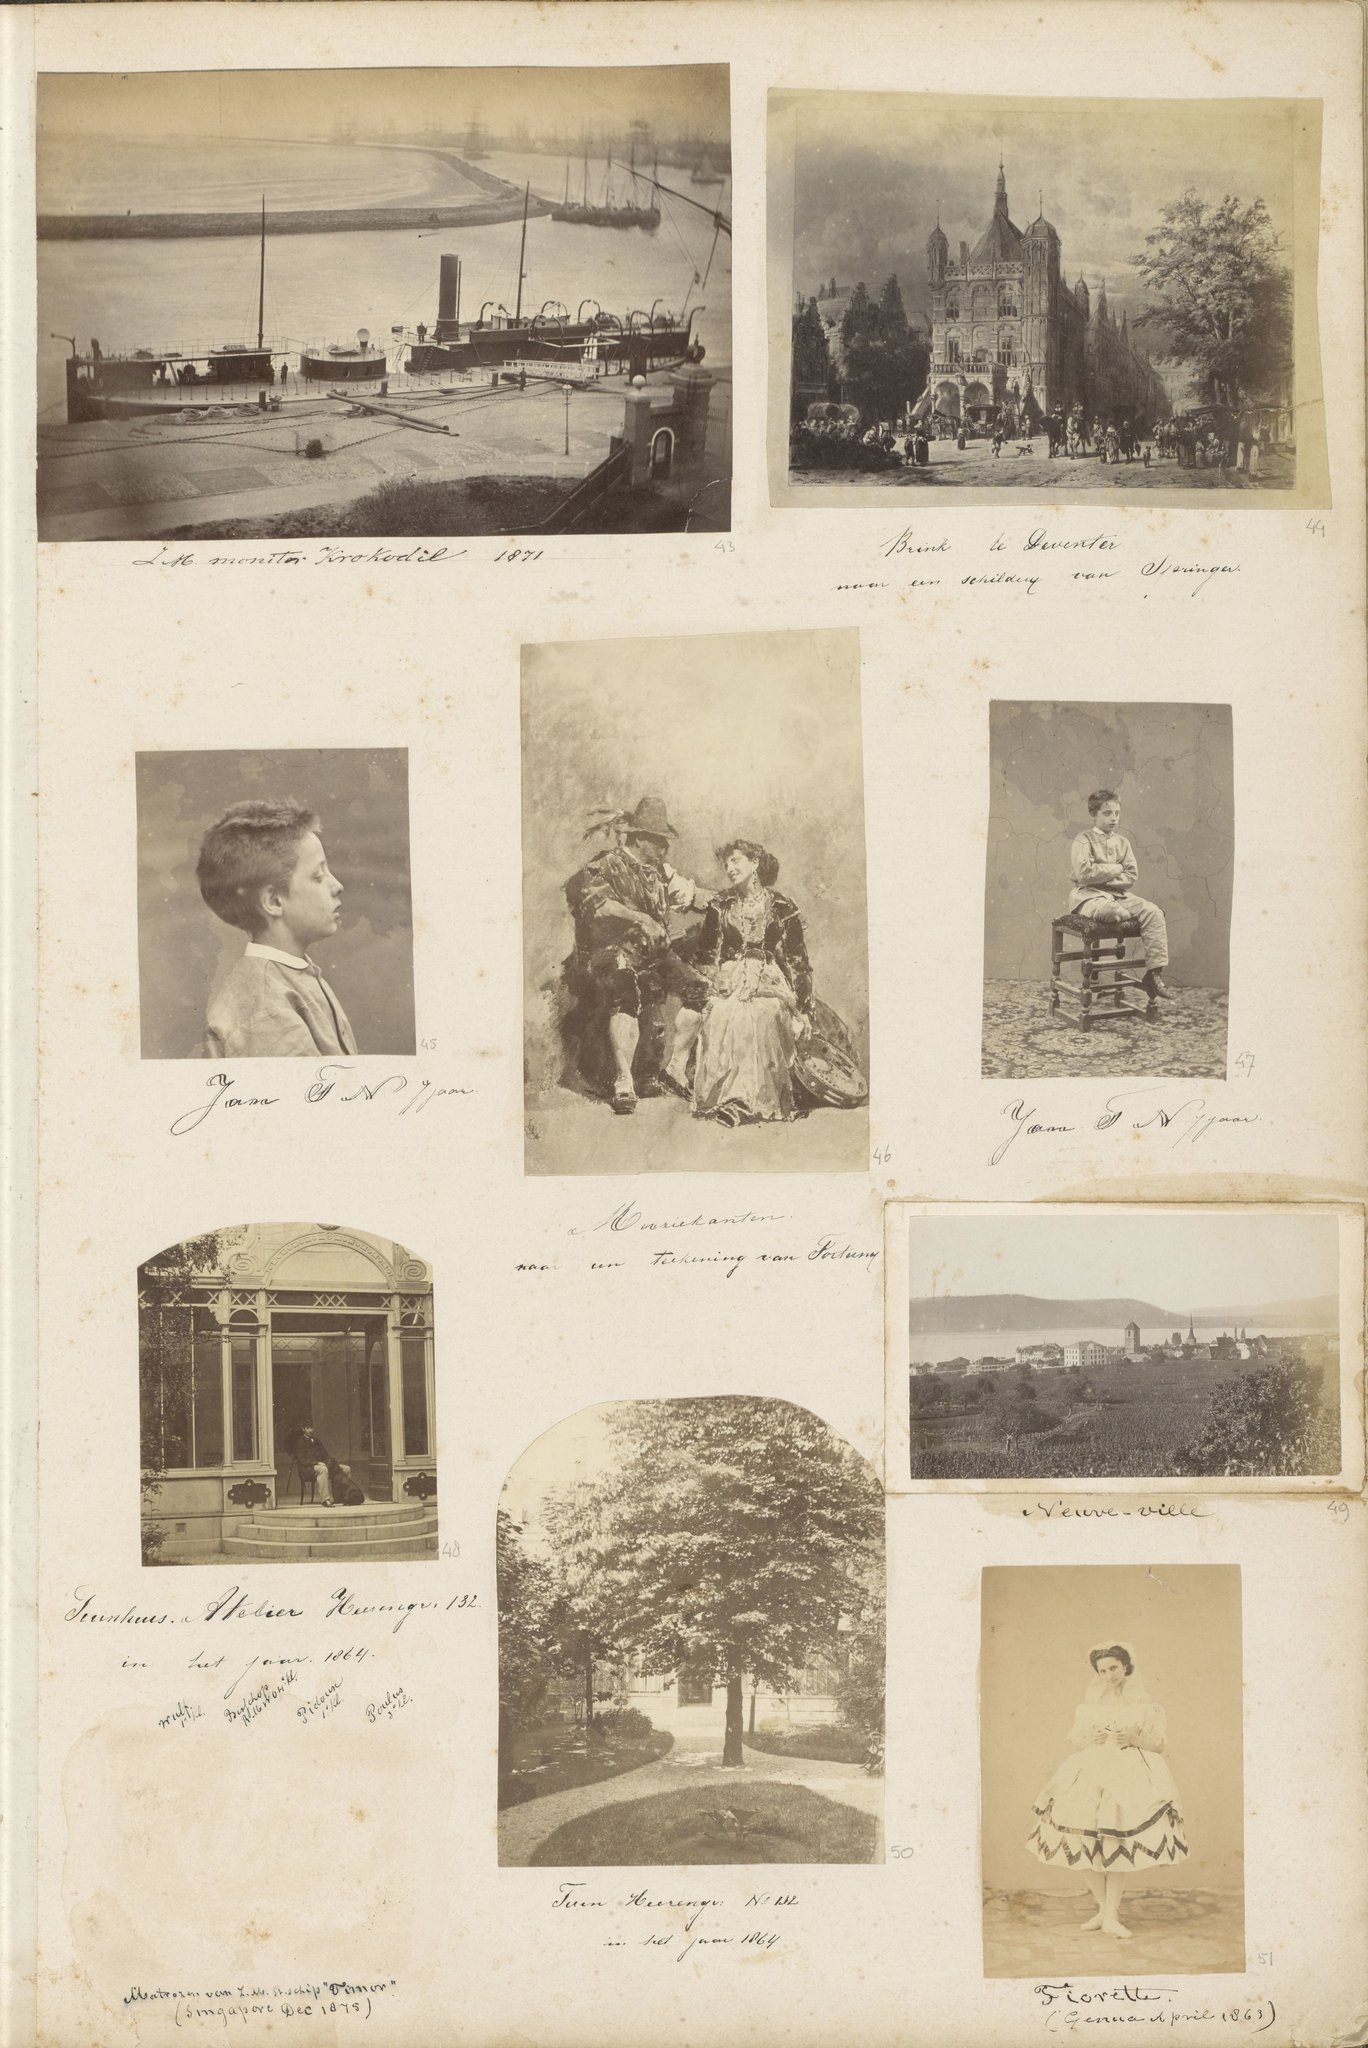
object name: photograph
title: Fotoreproductie van een schilderij van Cornelis Springer, voorstellend de brink te Deventer met het waaggebouw en een markt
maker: Anonymous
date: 1869-1880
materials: paper, photographic support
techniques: albumen print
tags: square, place, circus, etc., market, weigh-house, deventer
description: Onderdeel van Fotoalbum van Robert Daniel Crommelin (1841-1907).